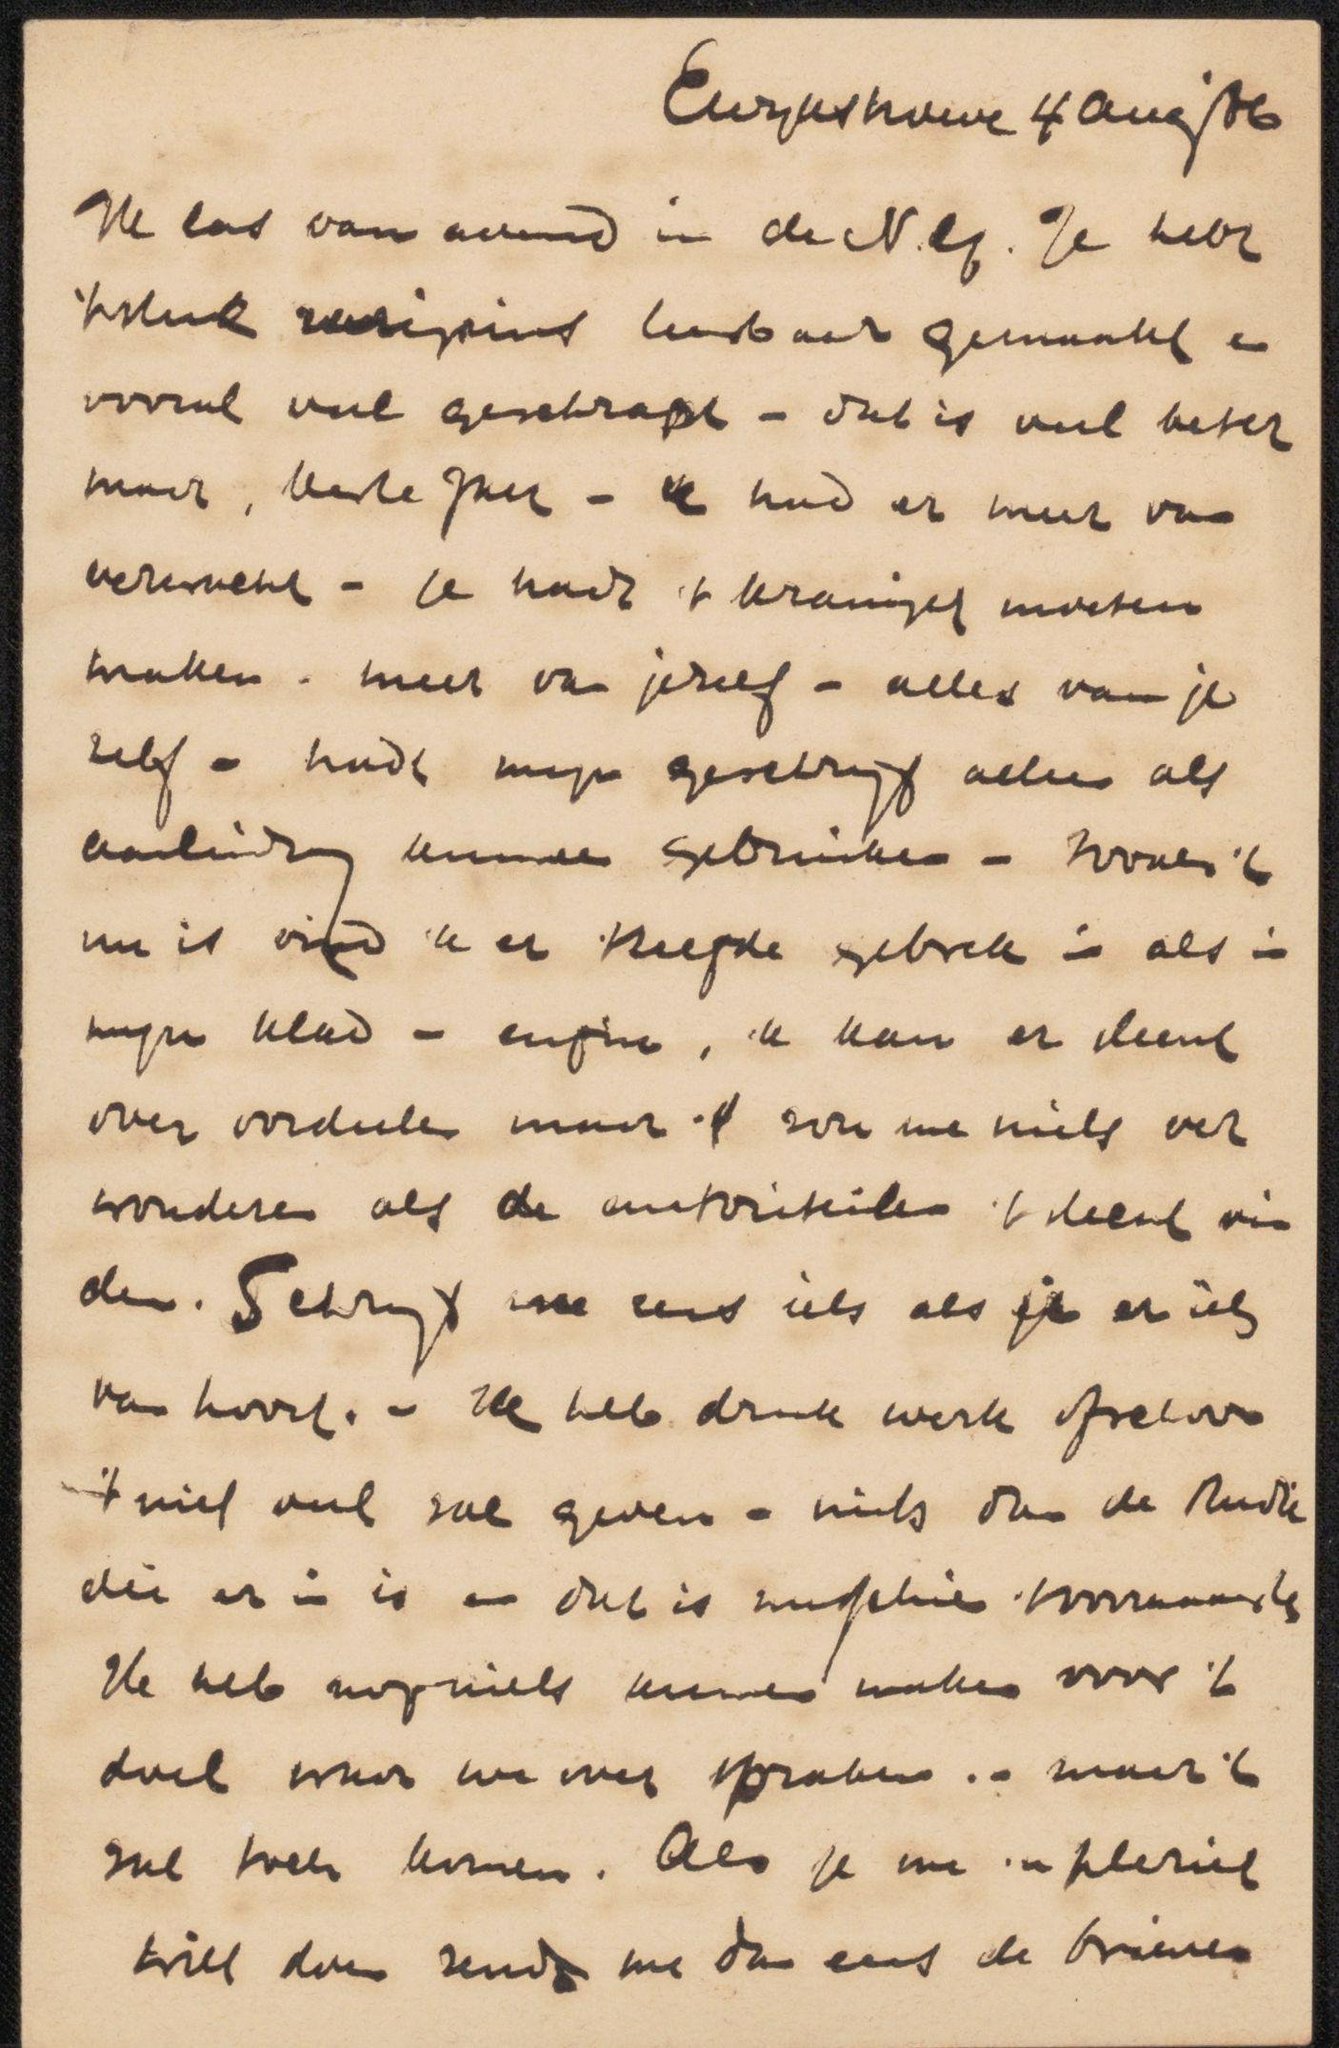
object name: letter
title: Brief aan Jan Veth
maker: willem witsen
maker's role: draughtsman, painter, print maker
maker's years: 1860-1923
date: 1886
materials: ink, paper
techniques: pen, writing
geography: ewijkshoeve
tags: designer, jan veth, haarlem, jac van looij, martinus mouton, the graphic arts, painting (including book-illumination, miniature-painting), exhibition ~ art, printed matter, the hague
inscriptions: collector's mark: ‘RPK’, watermark